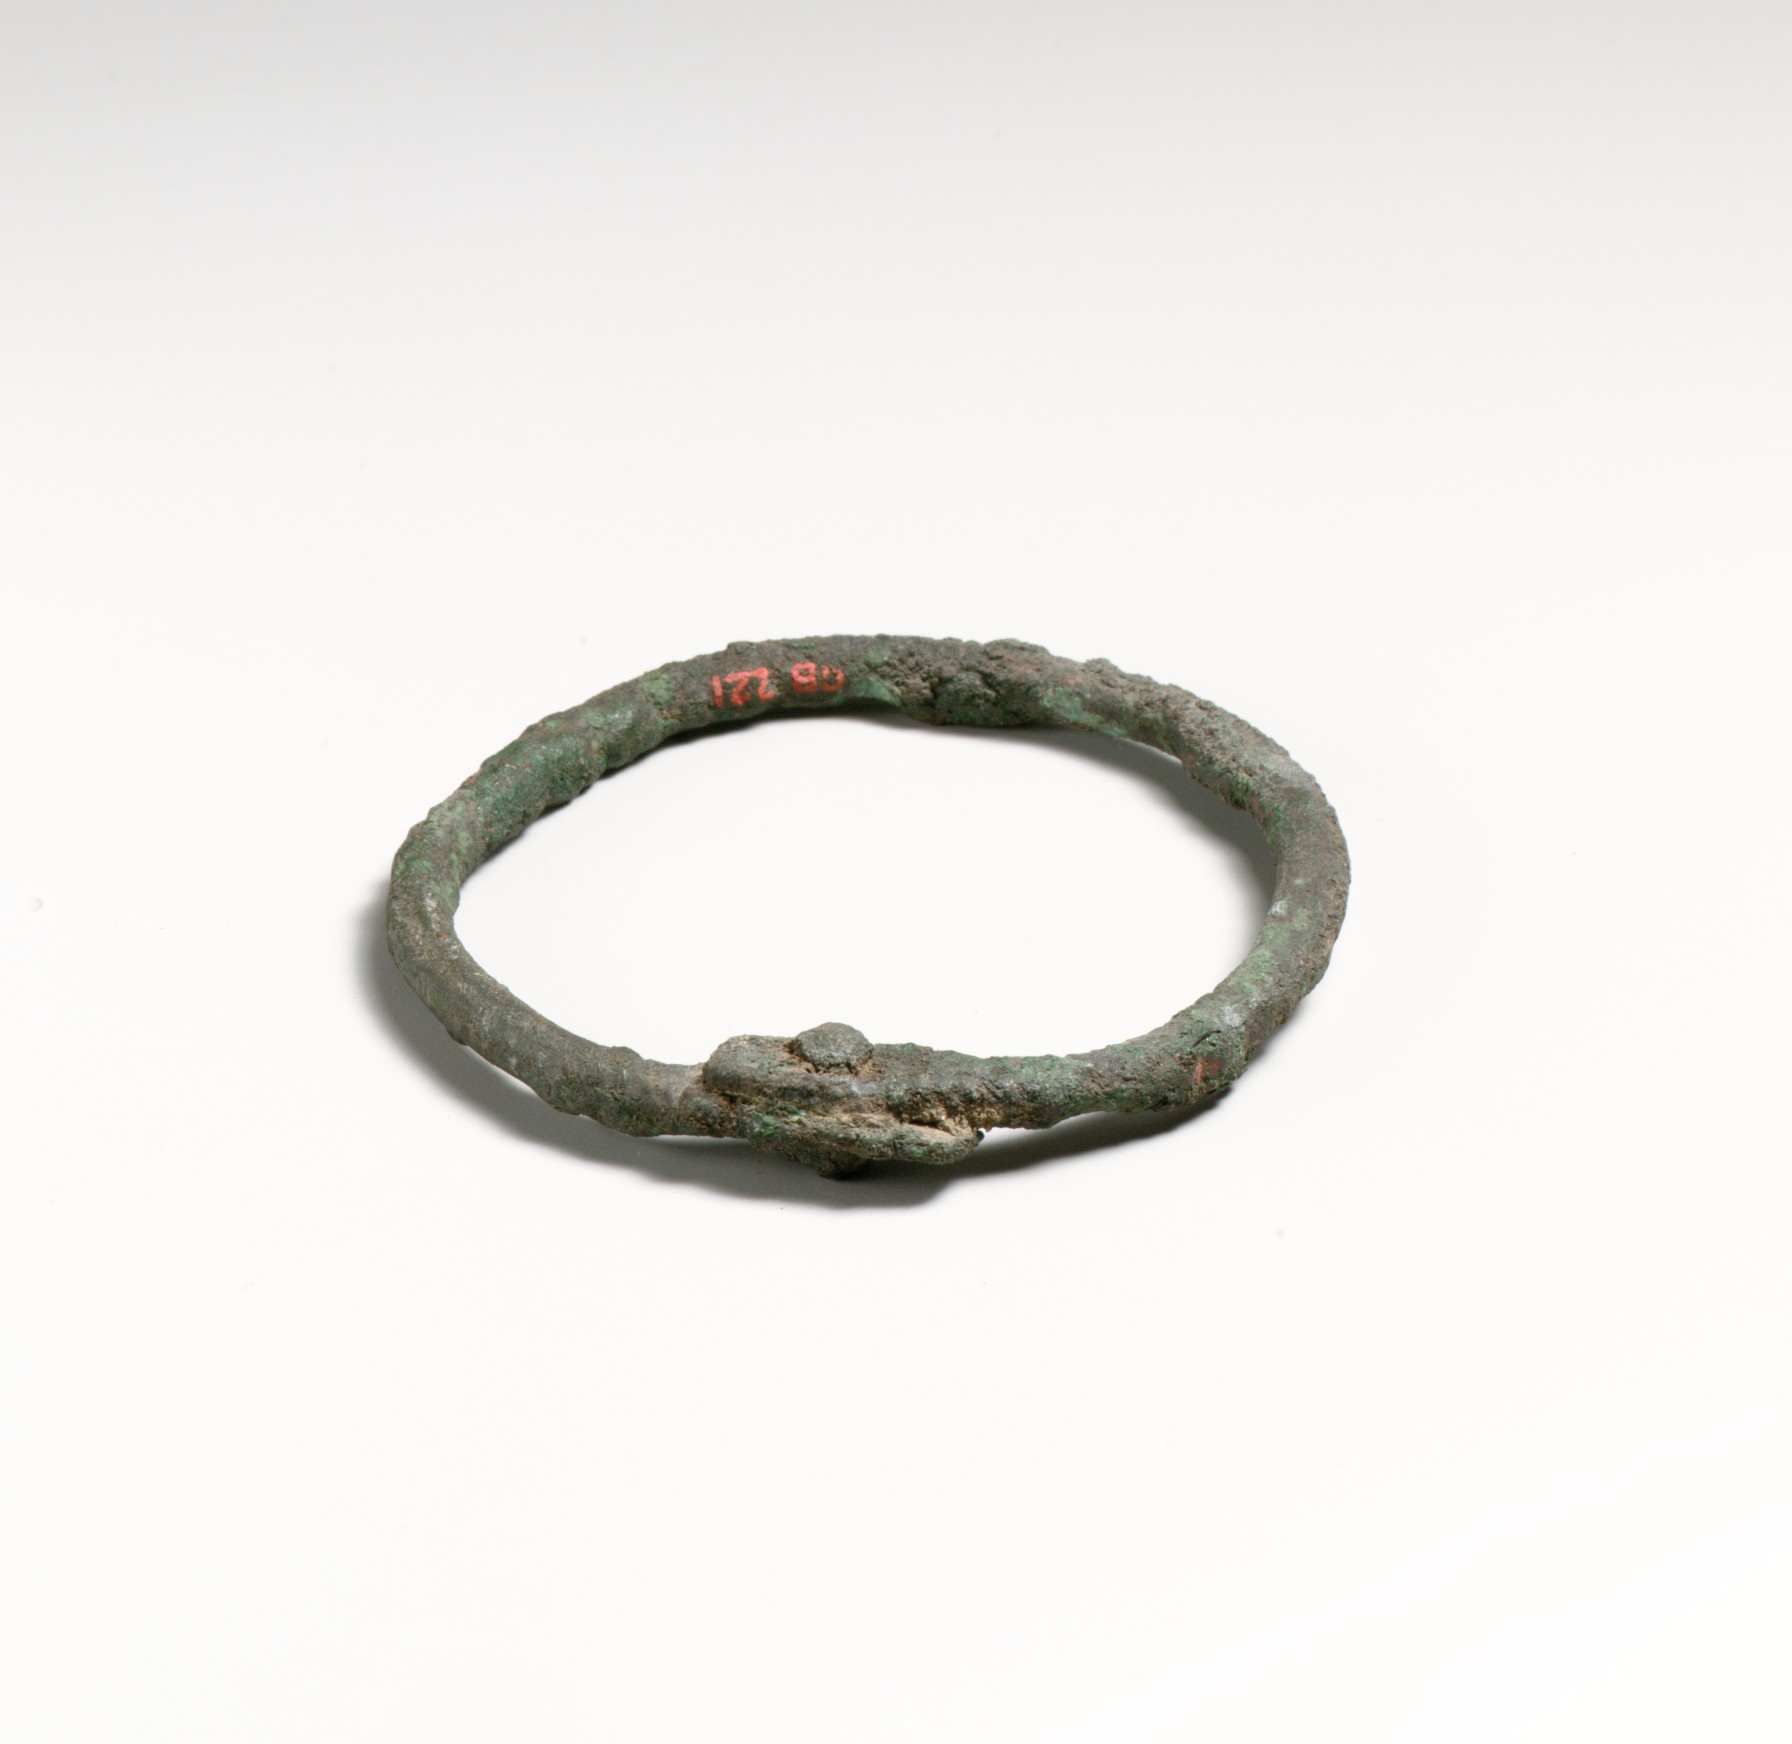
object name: bracelet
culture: cypriot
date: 3900 BCE-100 CE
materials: bronze